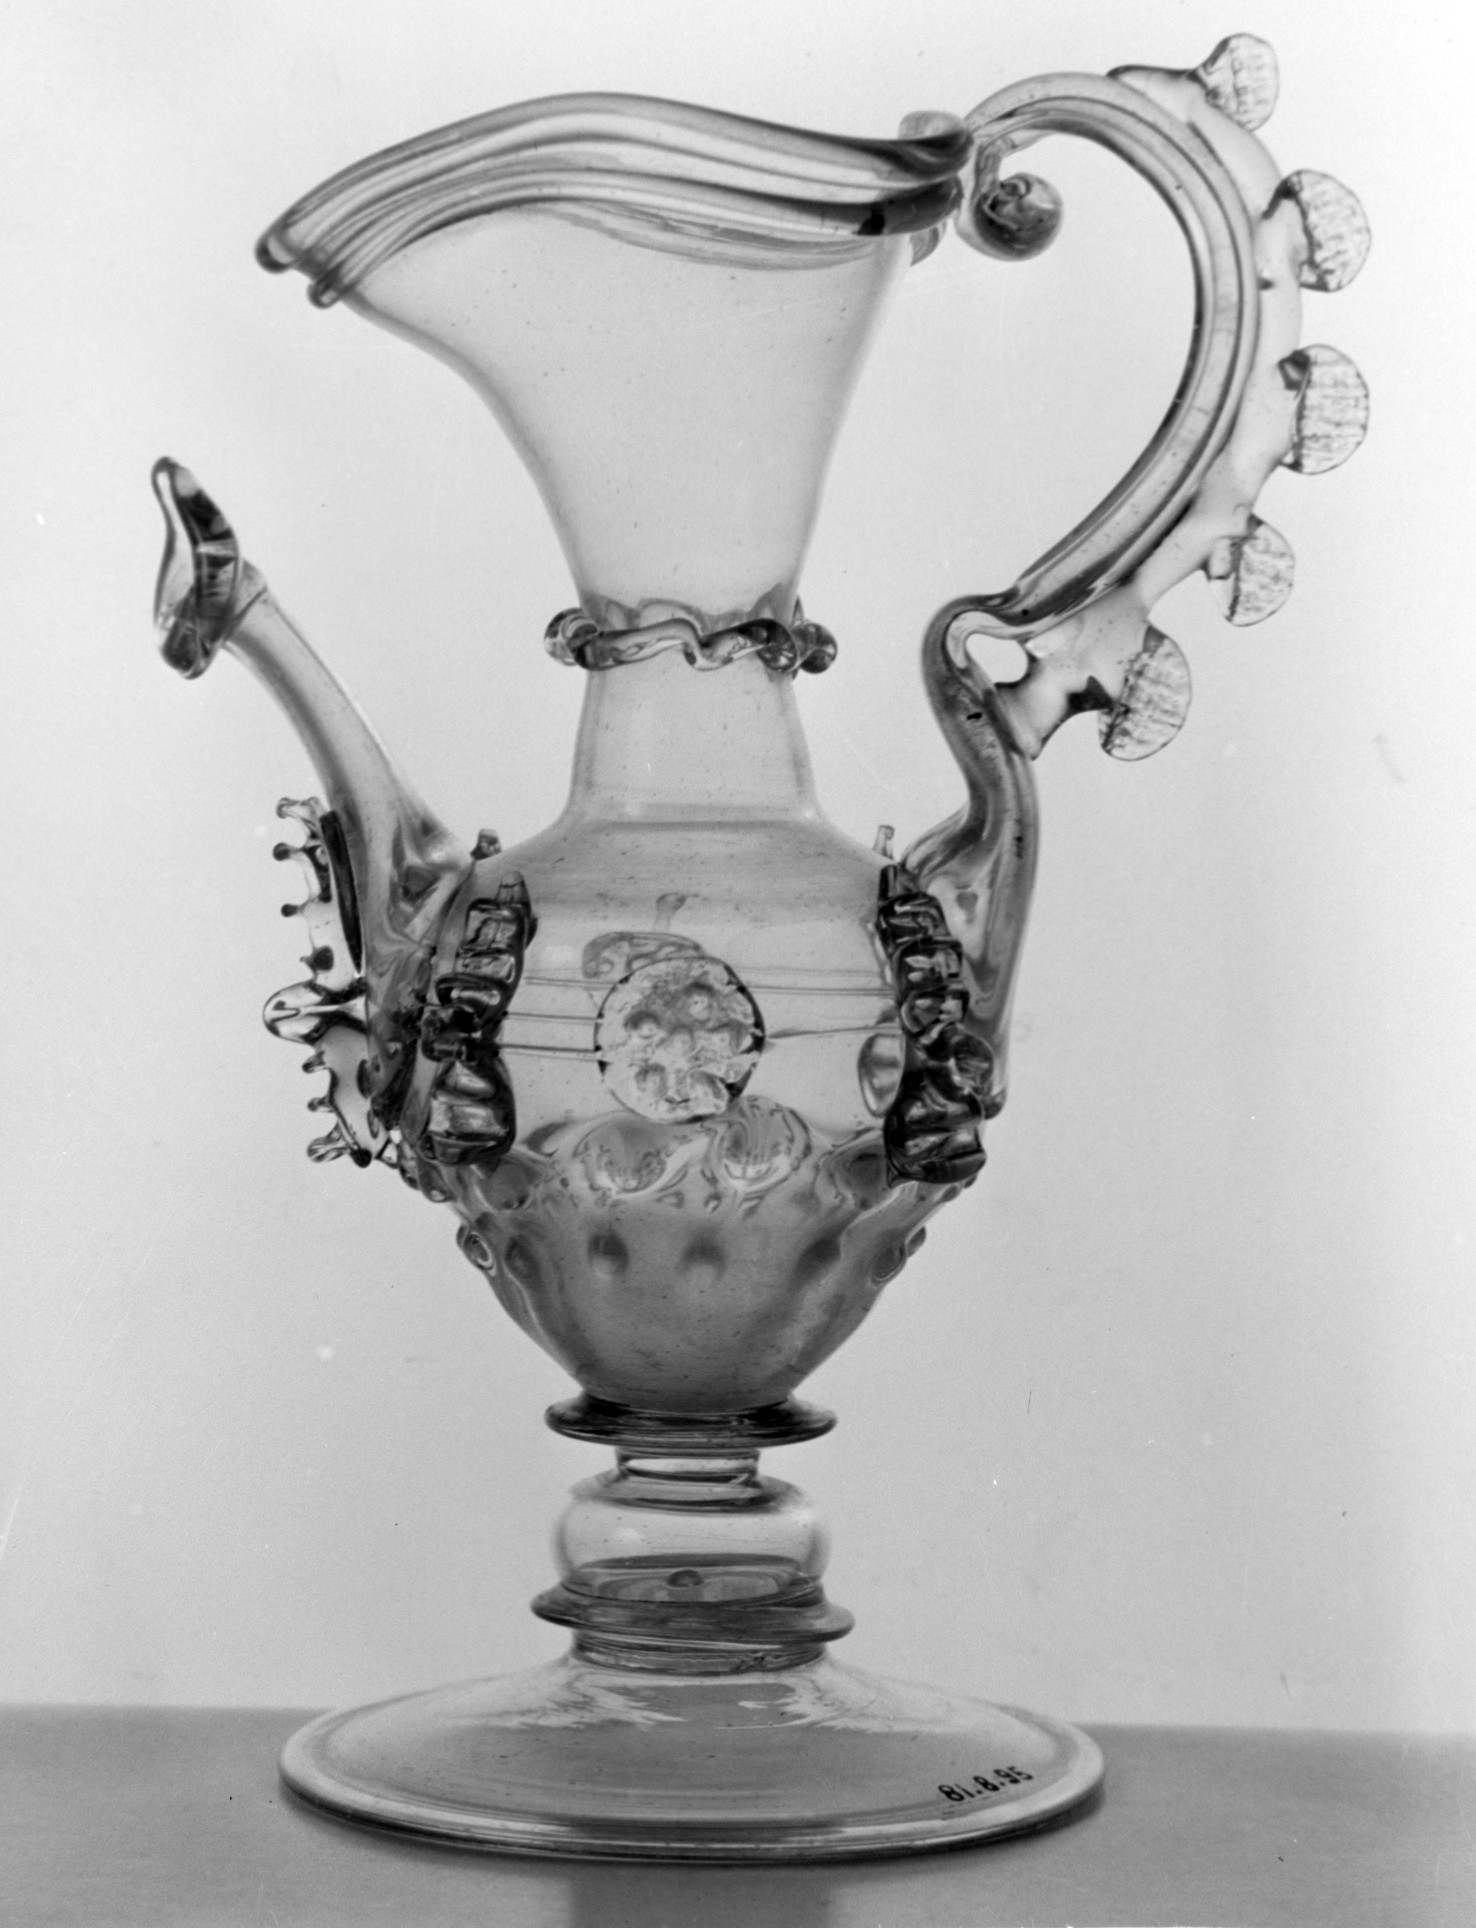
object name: ewer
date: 1601-1700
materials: glass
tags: human figures